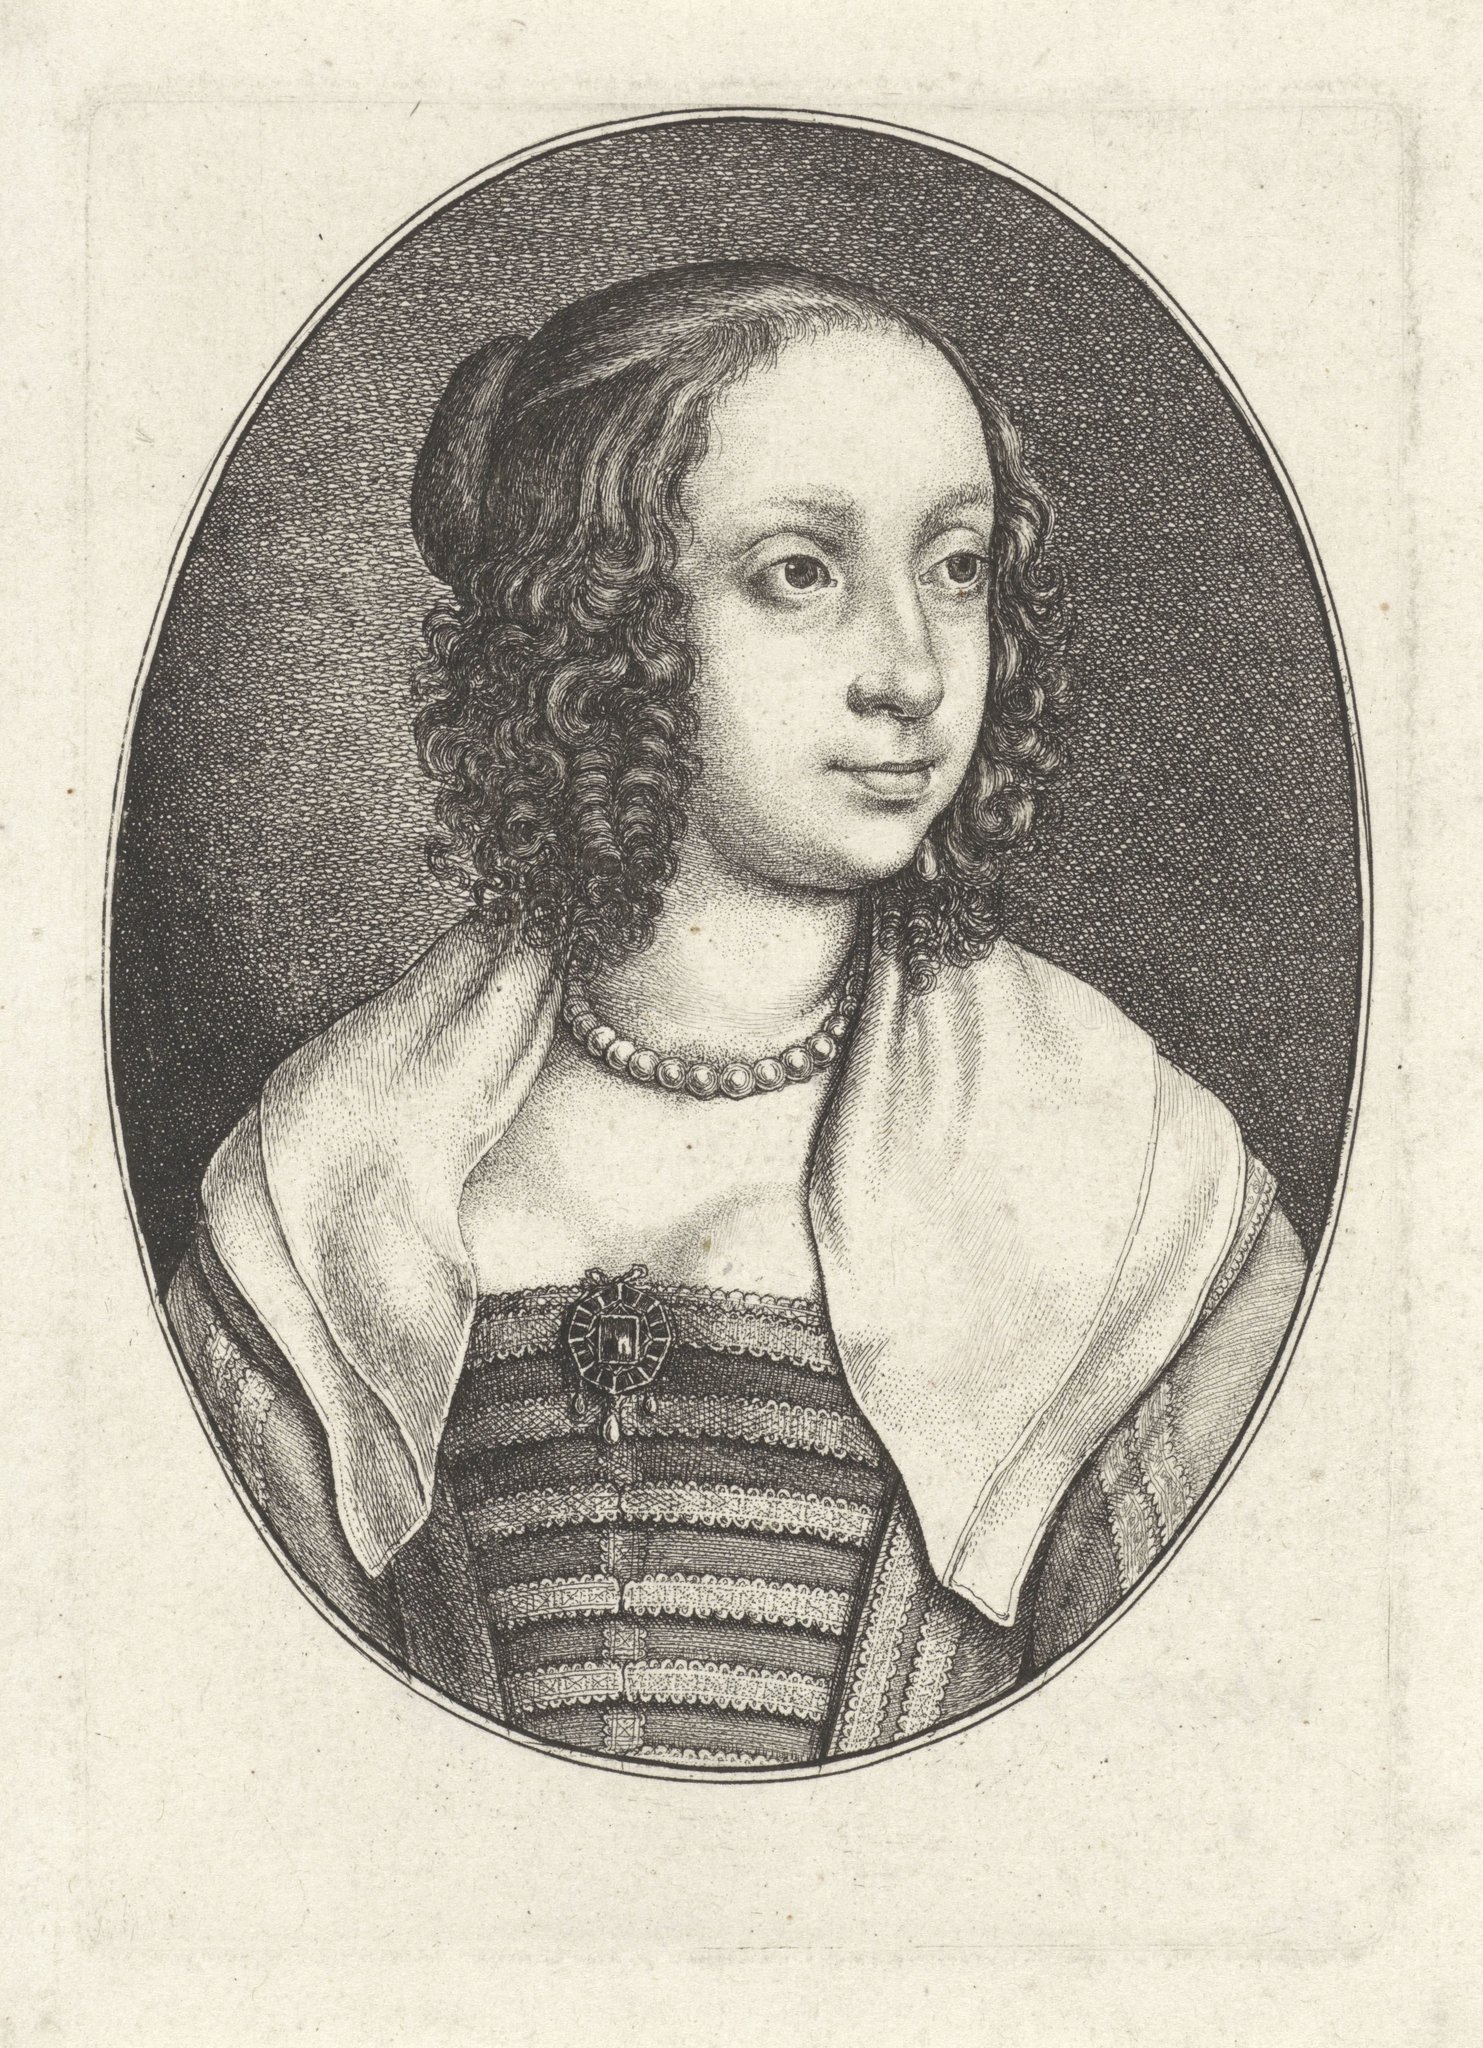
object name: print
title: Portret van Catharina Howard, koningin van Engeland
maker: wenceslaus hollar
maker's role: draughtsman, print maker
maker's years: 1607-1677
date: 1646-1648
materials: paper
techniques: etching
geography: antwerp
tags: hofdame, koningin, catharina howard (koningin van engeland)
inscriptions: collector's mark: Lugt 3554, collector's mark: Lugt 654